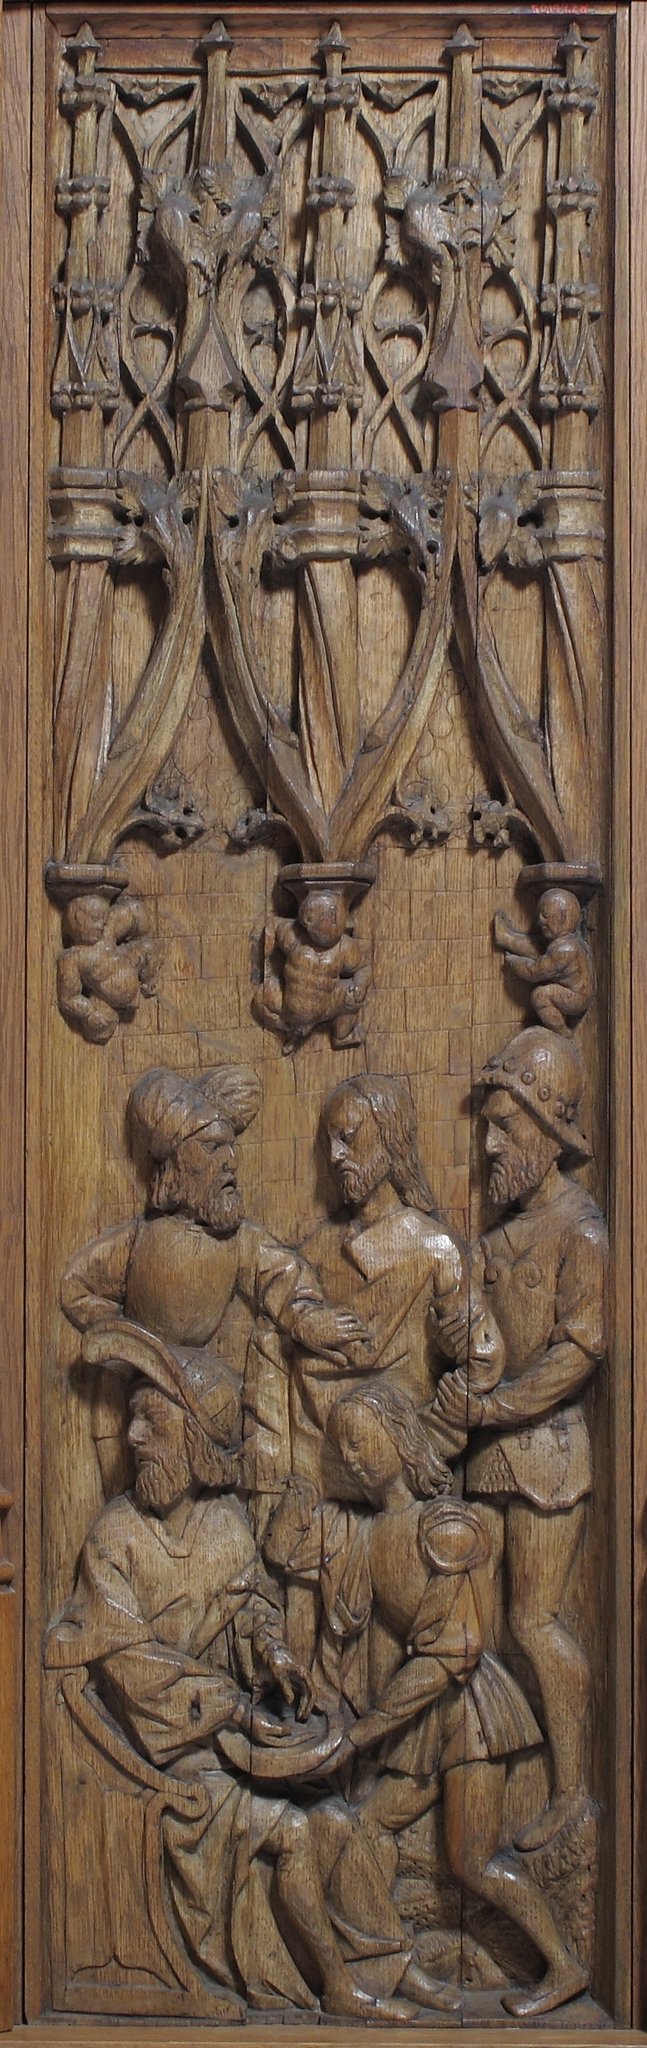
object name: panel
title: Panel with Pilate Washing his Hands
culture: french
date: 1501-1533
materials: wood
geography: france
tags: soldiers,christ,washing